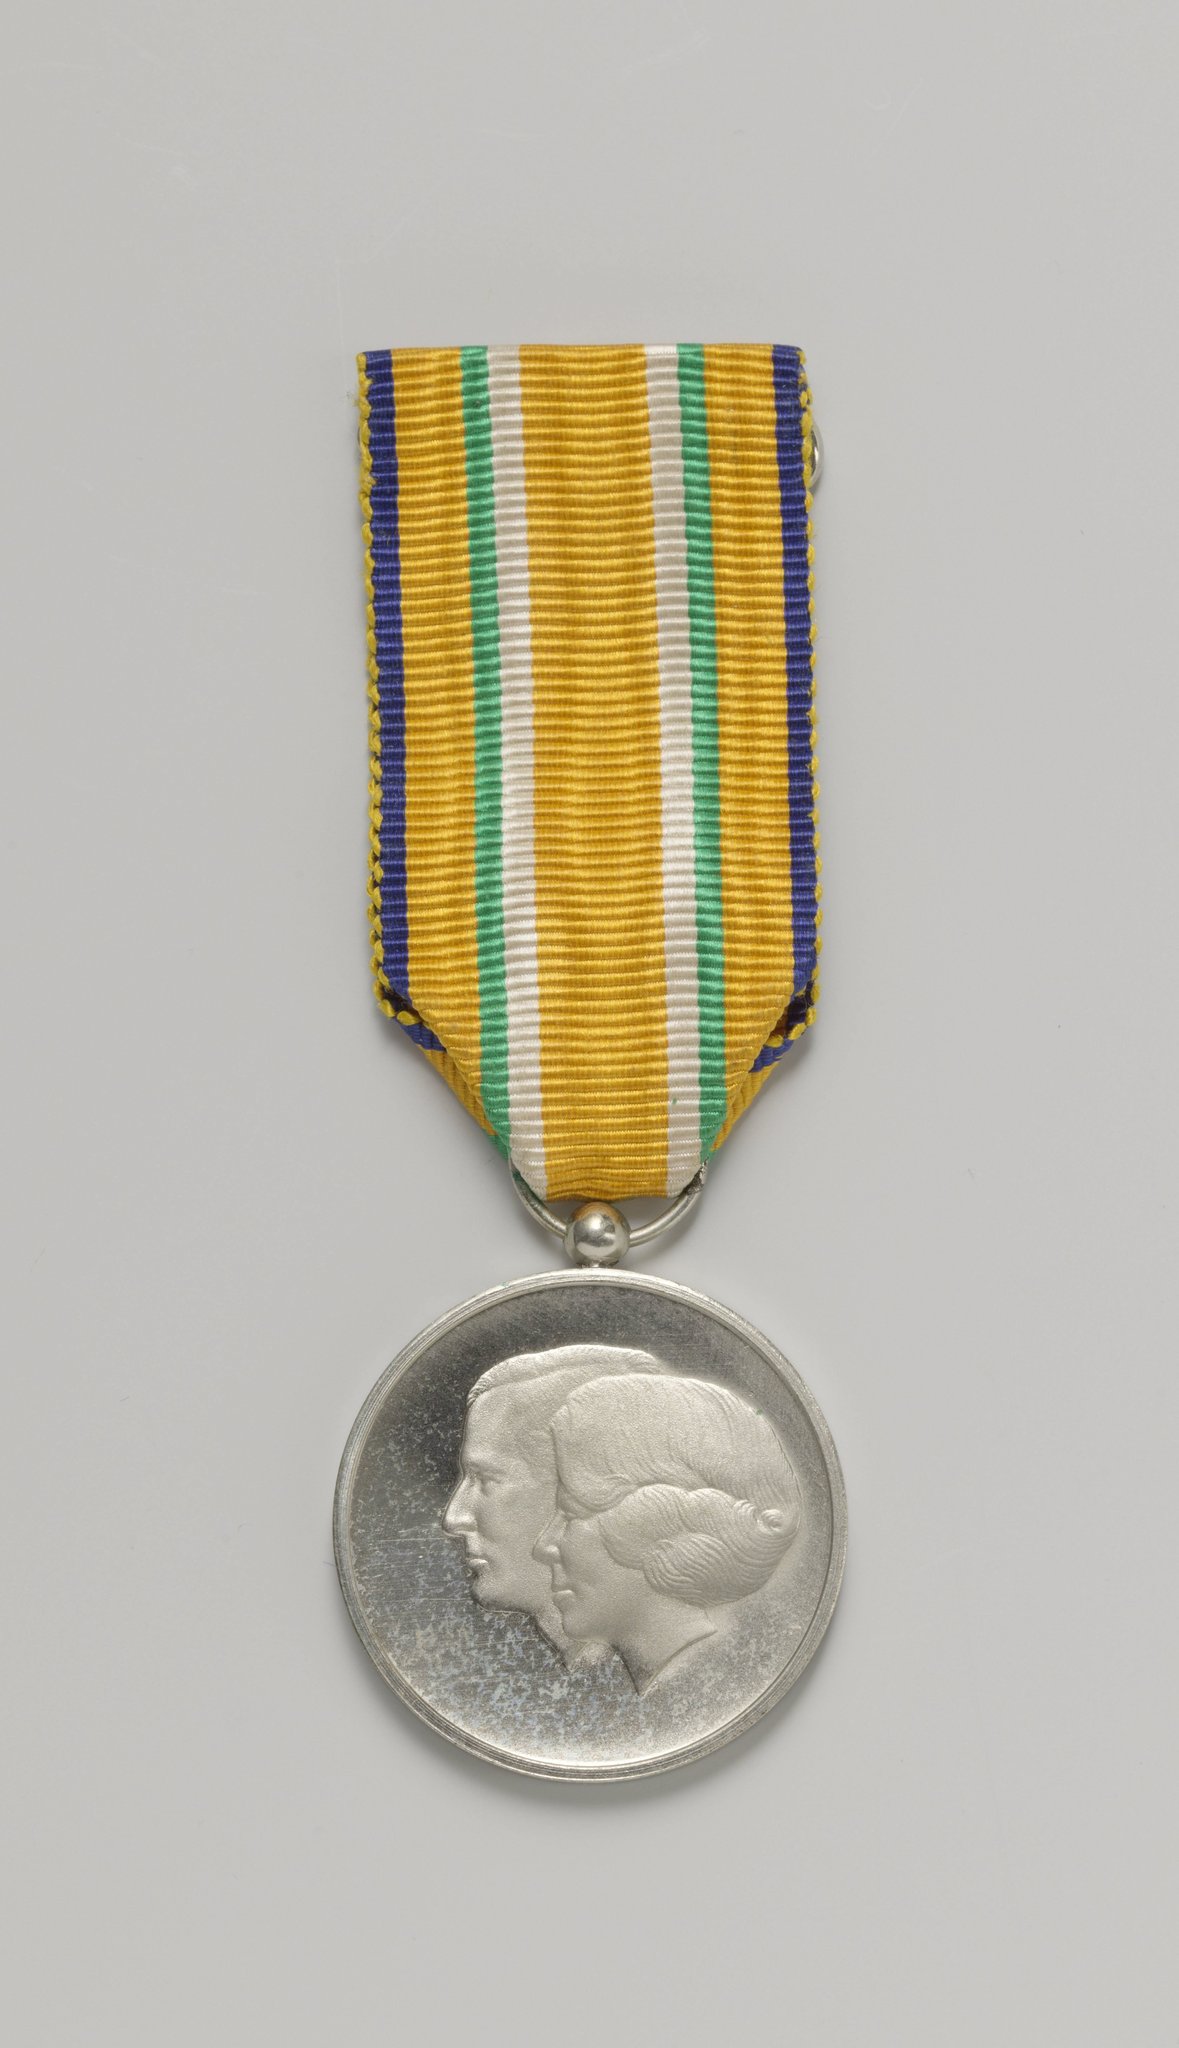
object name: marriage medal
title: Huwelijkspenning van huwelijk prinses Beatrix en Claus von Amsberg, 1966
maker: Anonymous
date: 1903-1966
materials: silver, textile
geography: netherlands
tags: beatrix (koningin der nederlanden), amsterdam, the hague, willem drees, netherlands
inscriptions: inscription: ‘CB’, date: ‘10 MAART 1966’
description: Zilveren penning aan draagring en oranje lint met met donkerblauwe banen aan de uiteinden en in het midden twee banen van groen en wit, aan speld. Voorzijde: Beatrix en Claus, met profiel naar links. Keerzijde: gekroonde CB en datum. Gemerkt op rand.